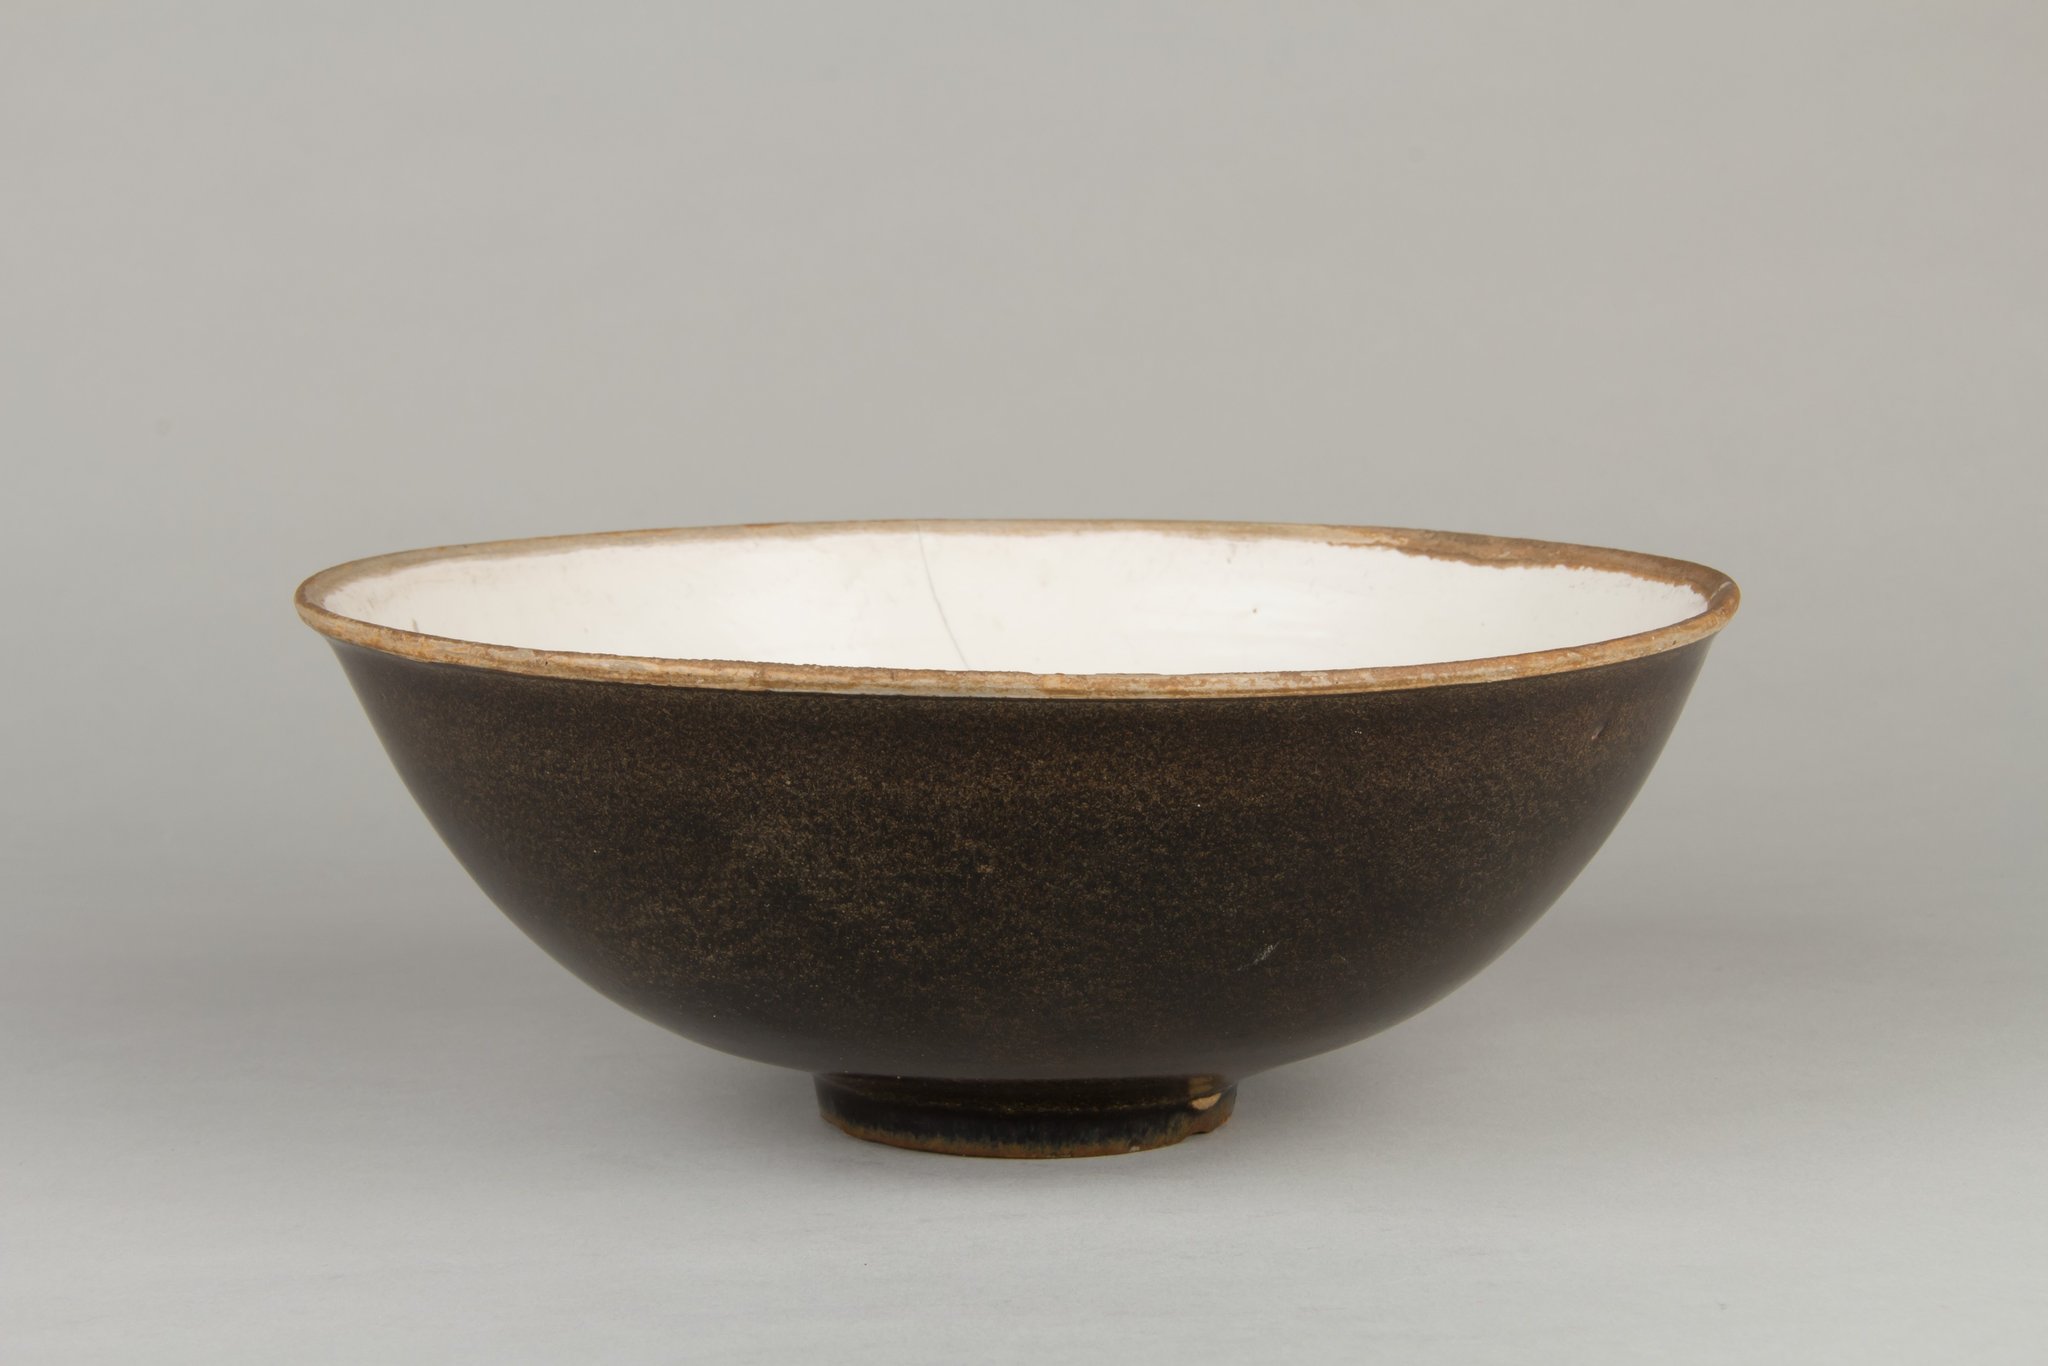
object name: bowl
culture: chinese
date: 1201-1400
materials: glaze, porcelain